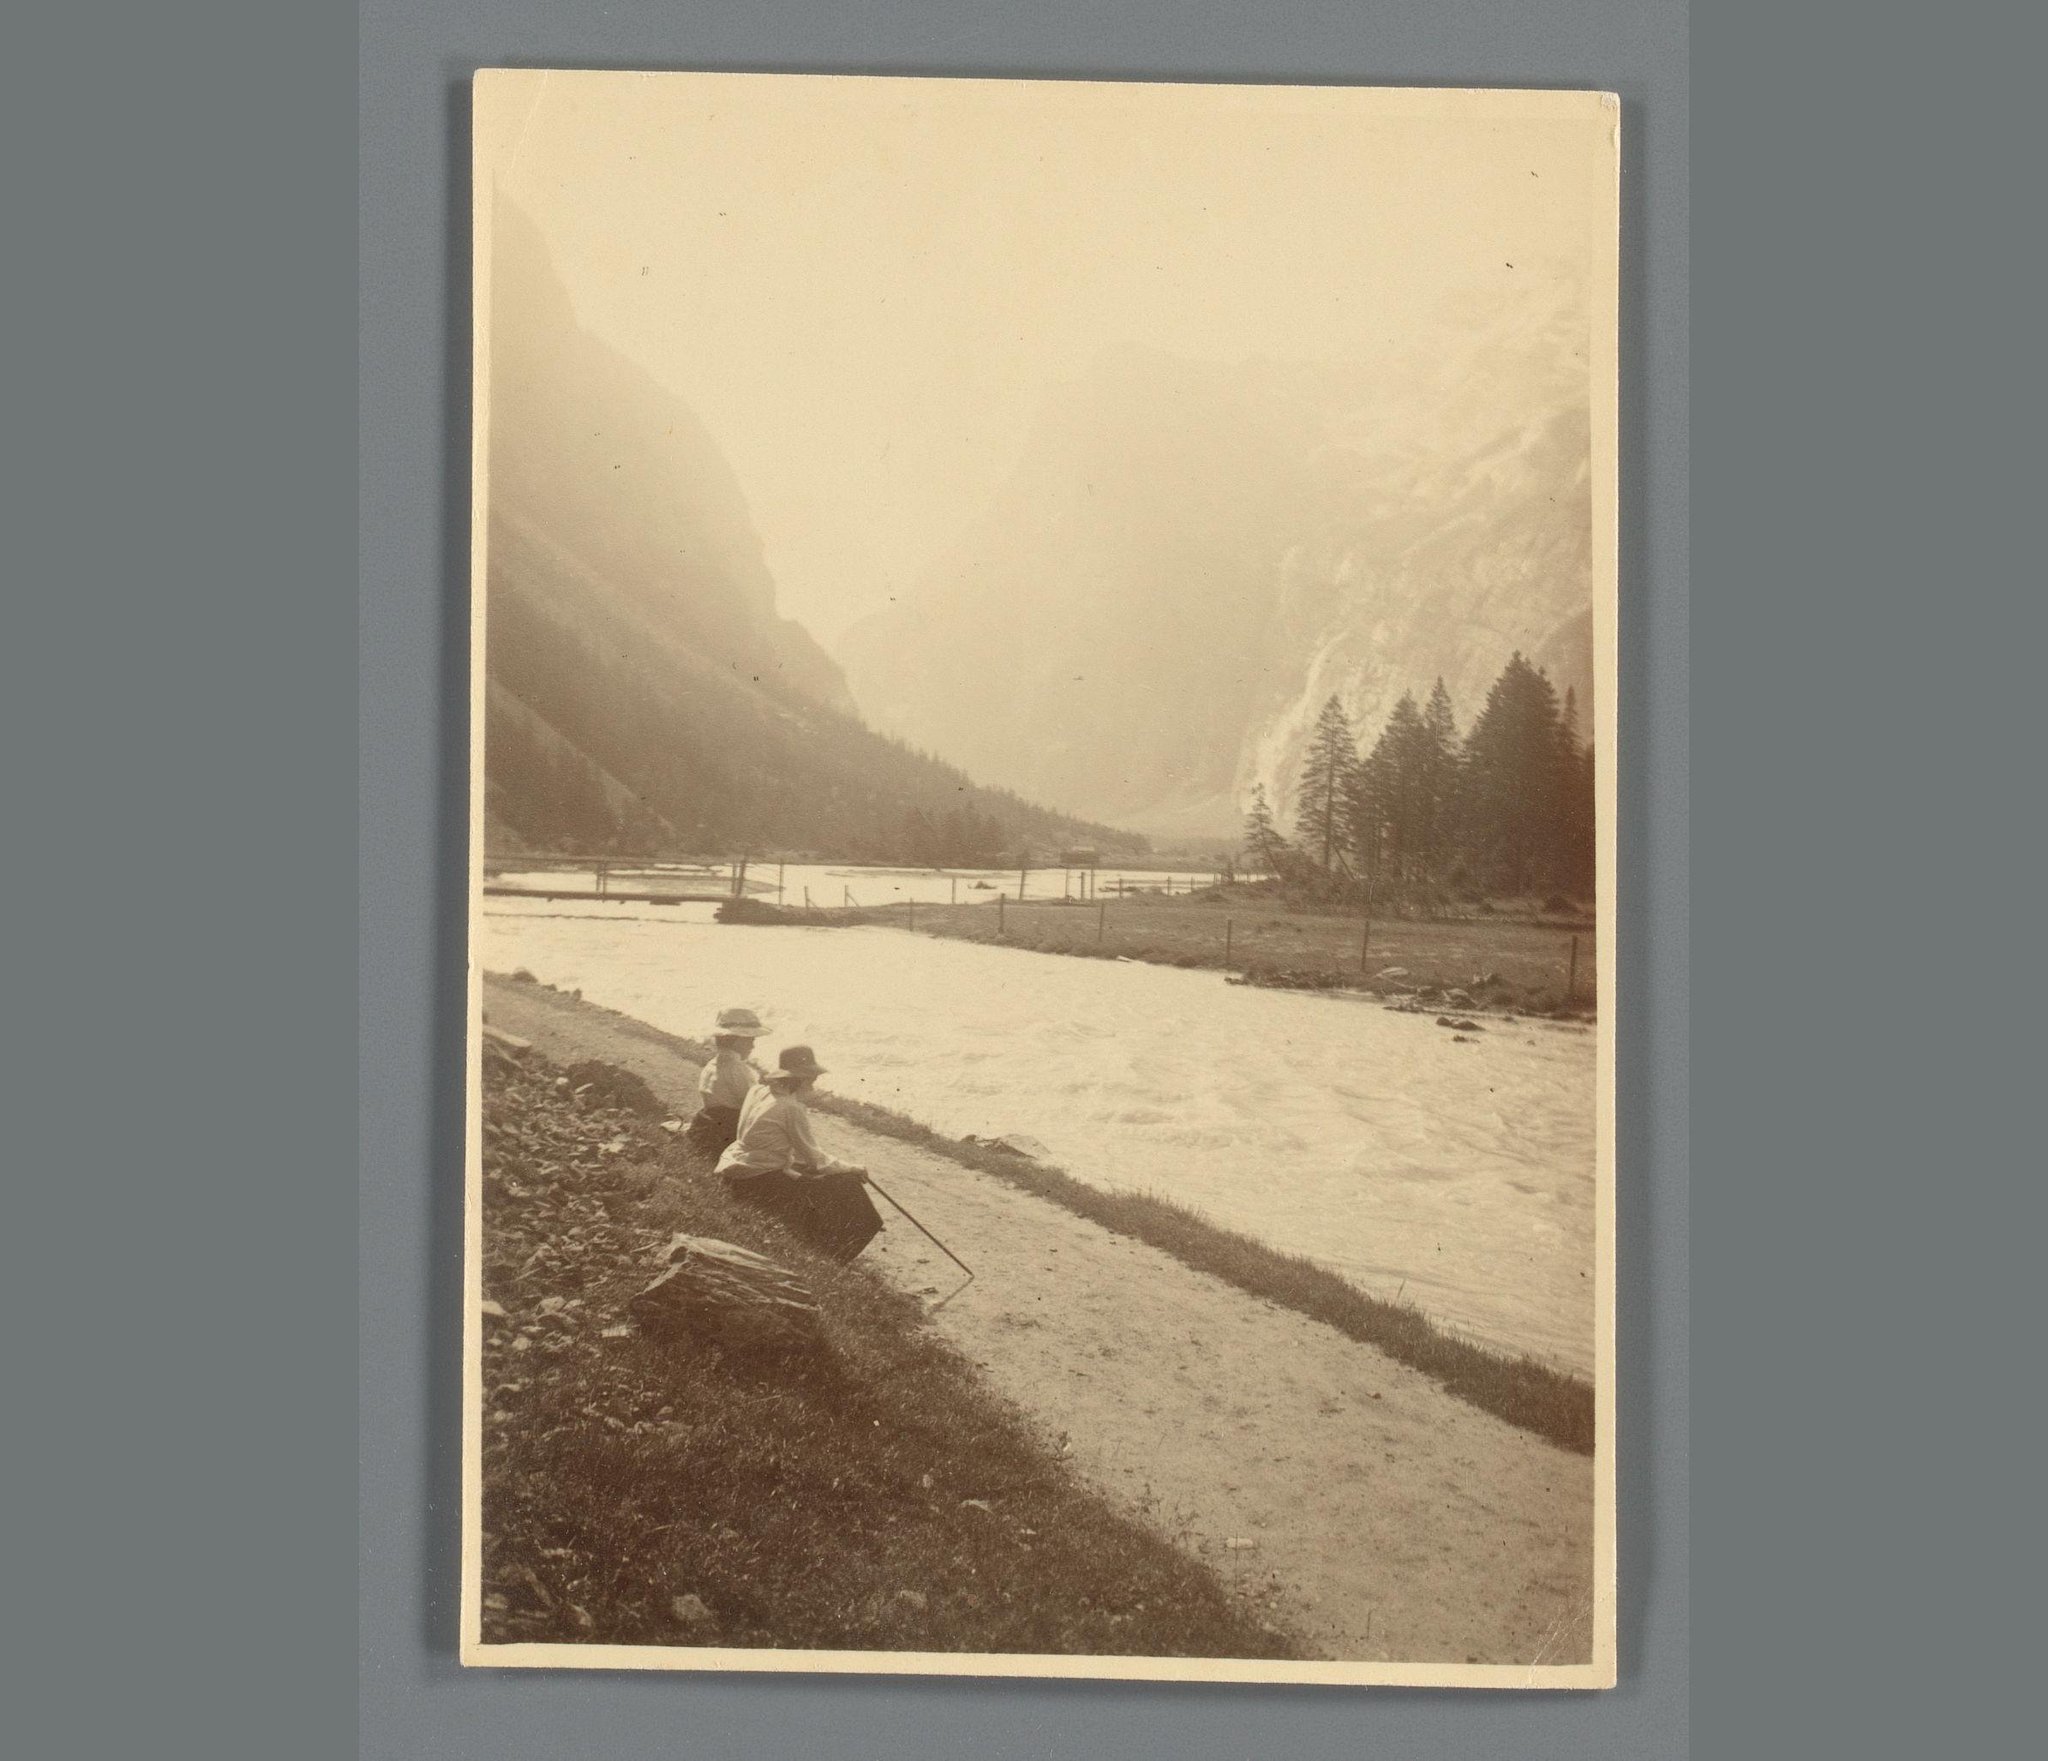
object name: photograph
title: Johanna (Hans) de Jong en Elisabeth de Jong zittend bij een rivier in Kandersteg, Zwitserland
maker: willem de jong (fotograaf)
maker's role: arts, fotograaf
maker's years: 1864-1918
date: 1914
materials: paper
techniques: gelatin silver print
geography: switzerland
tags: elisabeth de jong-van tonderen, johanna petronella lambertina stokhuyzen-de jong (hans), river, sitting on the ground, mountains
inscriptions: inscription: ‘Kandersteg’